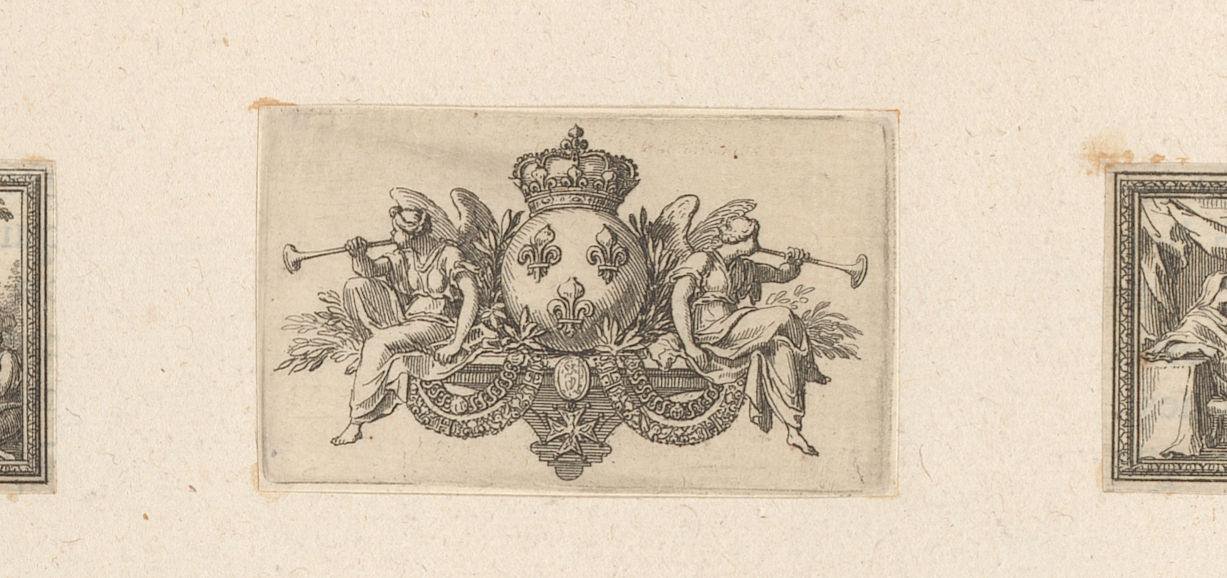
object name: book illustration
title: Cul-de-lampe met blazoen blazende engelen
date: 1680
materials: paper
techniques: etching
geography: paris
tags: angels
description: Prent gebruikt voor: Tallemant, Abbé Paul. Panegyriques et harangues à la louange du Roy (...). Parijs: Pierre Le Petit, 1680.